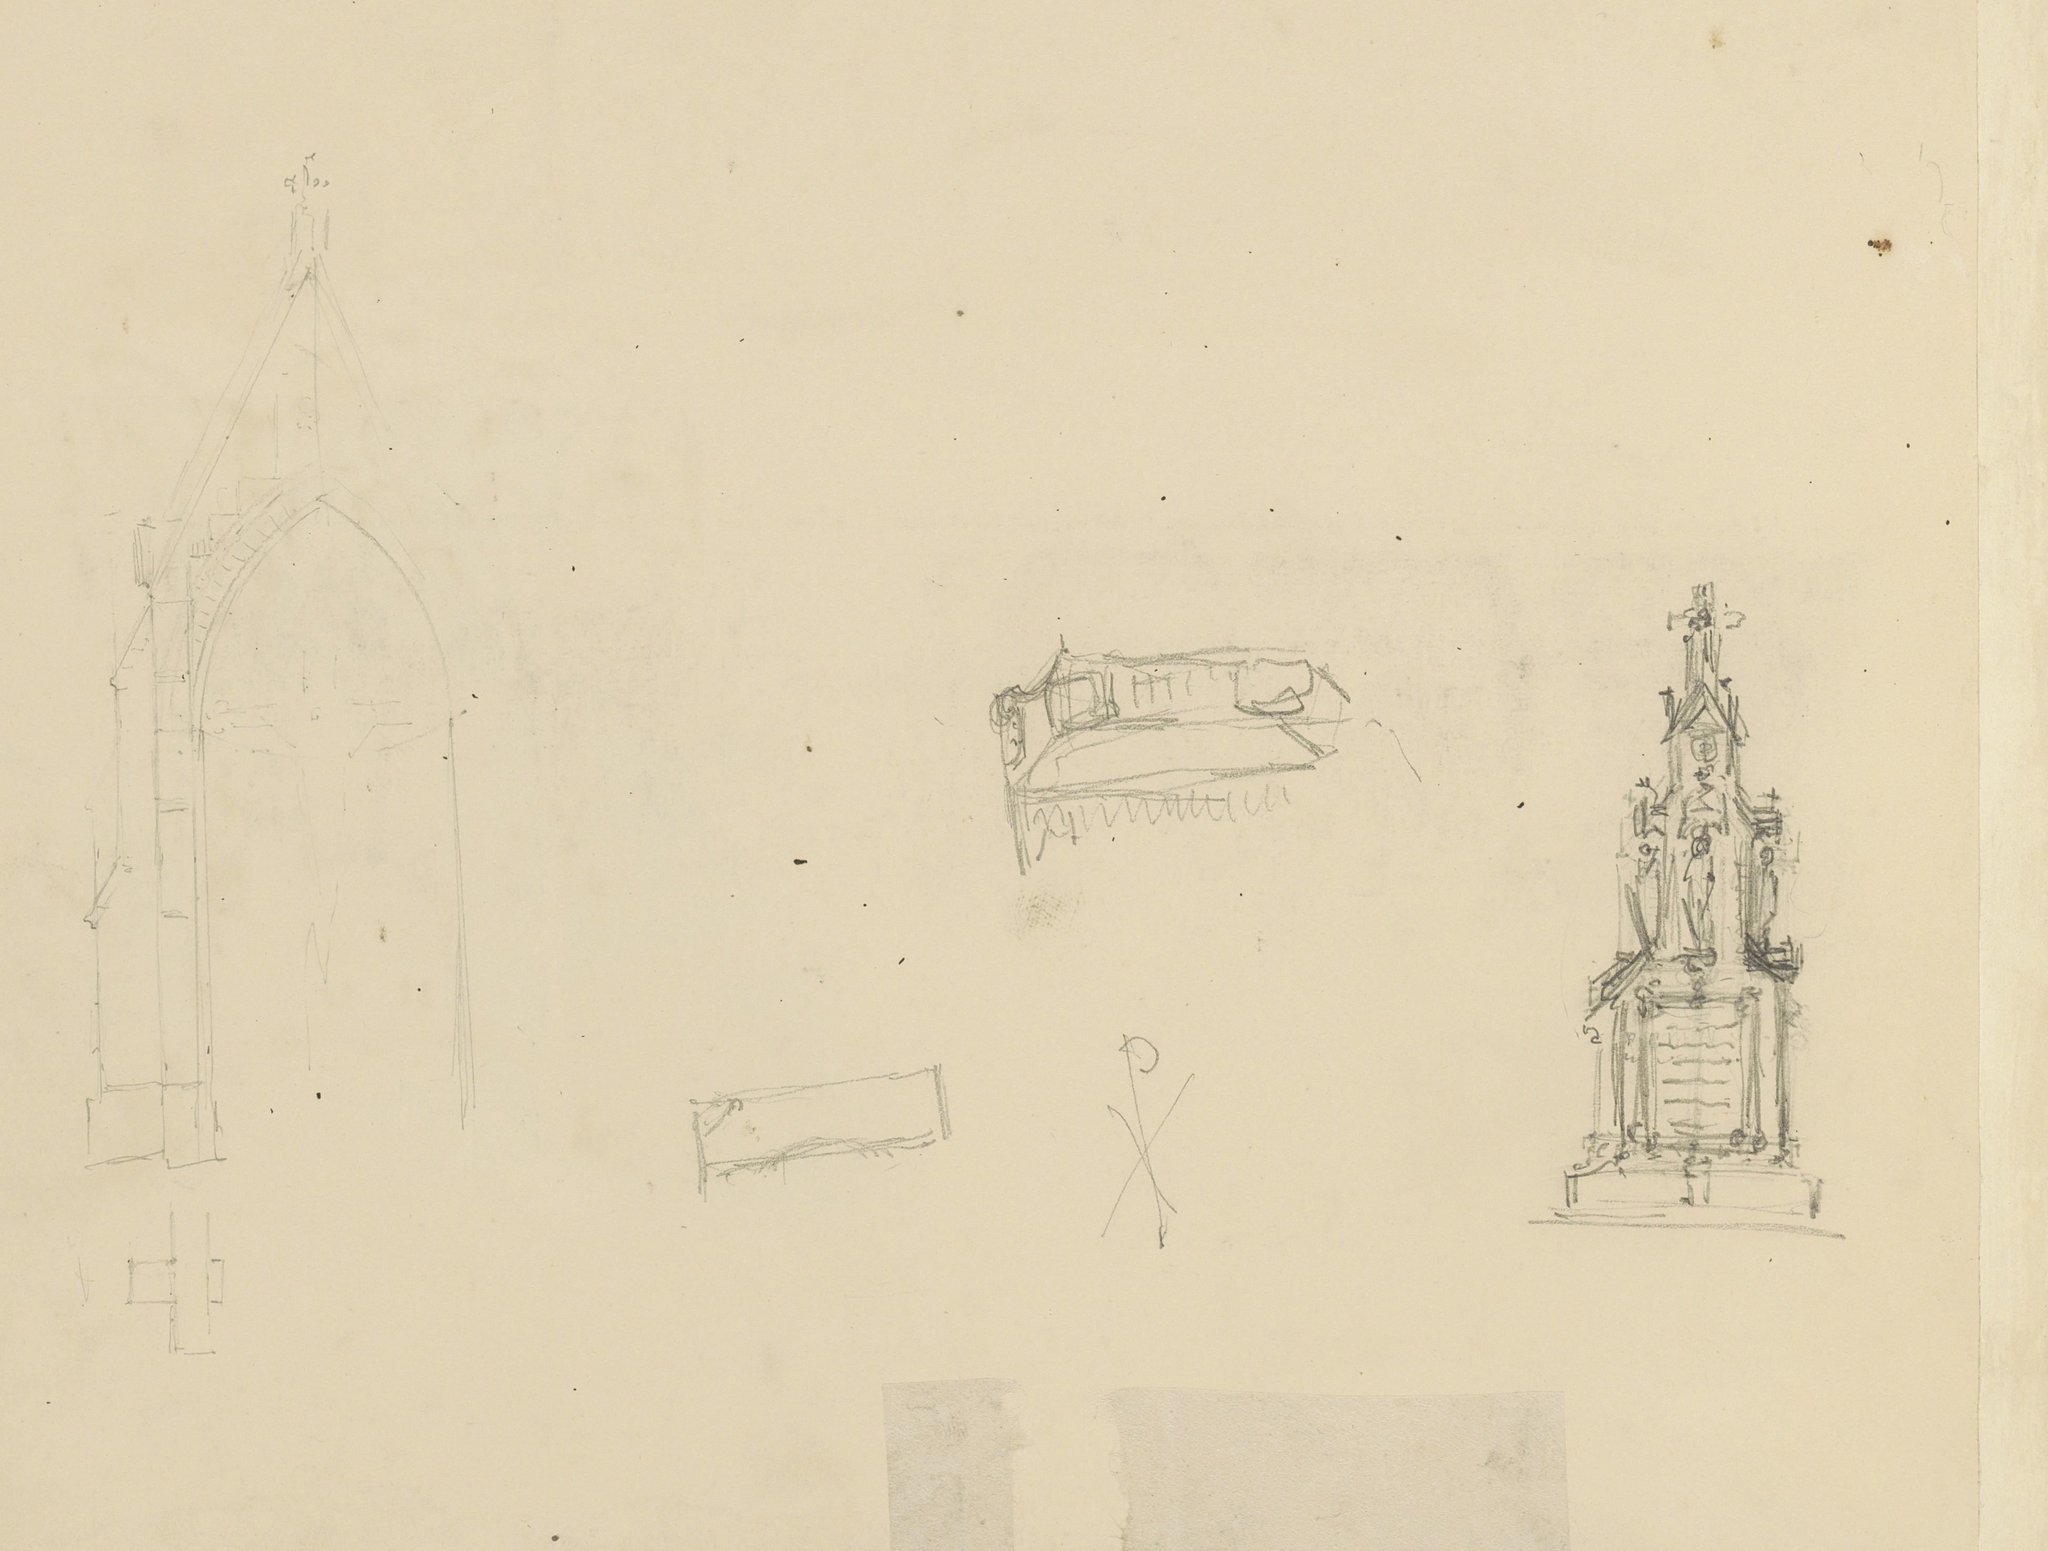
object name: sketchbook leaf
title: Monumenten en een bank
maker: pierre joseph hubert cuypers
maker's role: draughtsman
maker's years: 1827-1921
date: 1850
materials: paper, pencil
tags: bench, monument, statue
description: Blad 27 verso uit een schetsboek met 37 bladen.